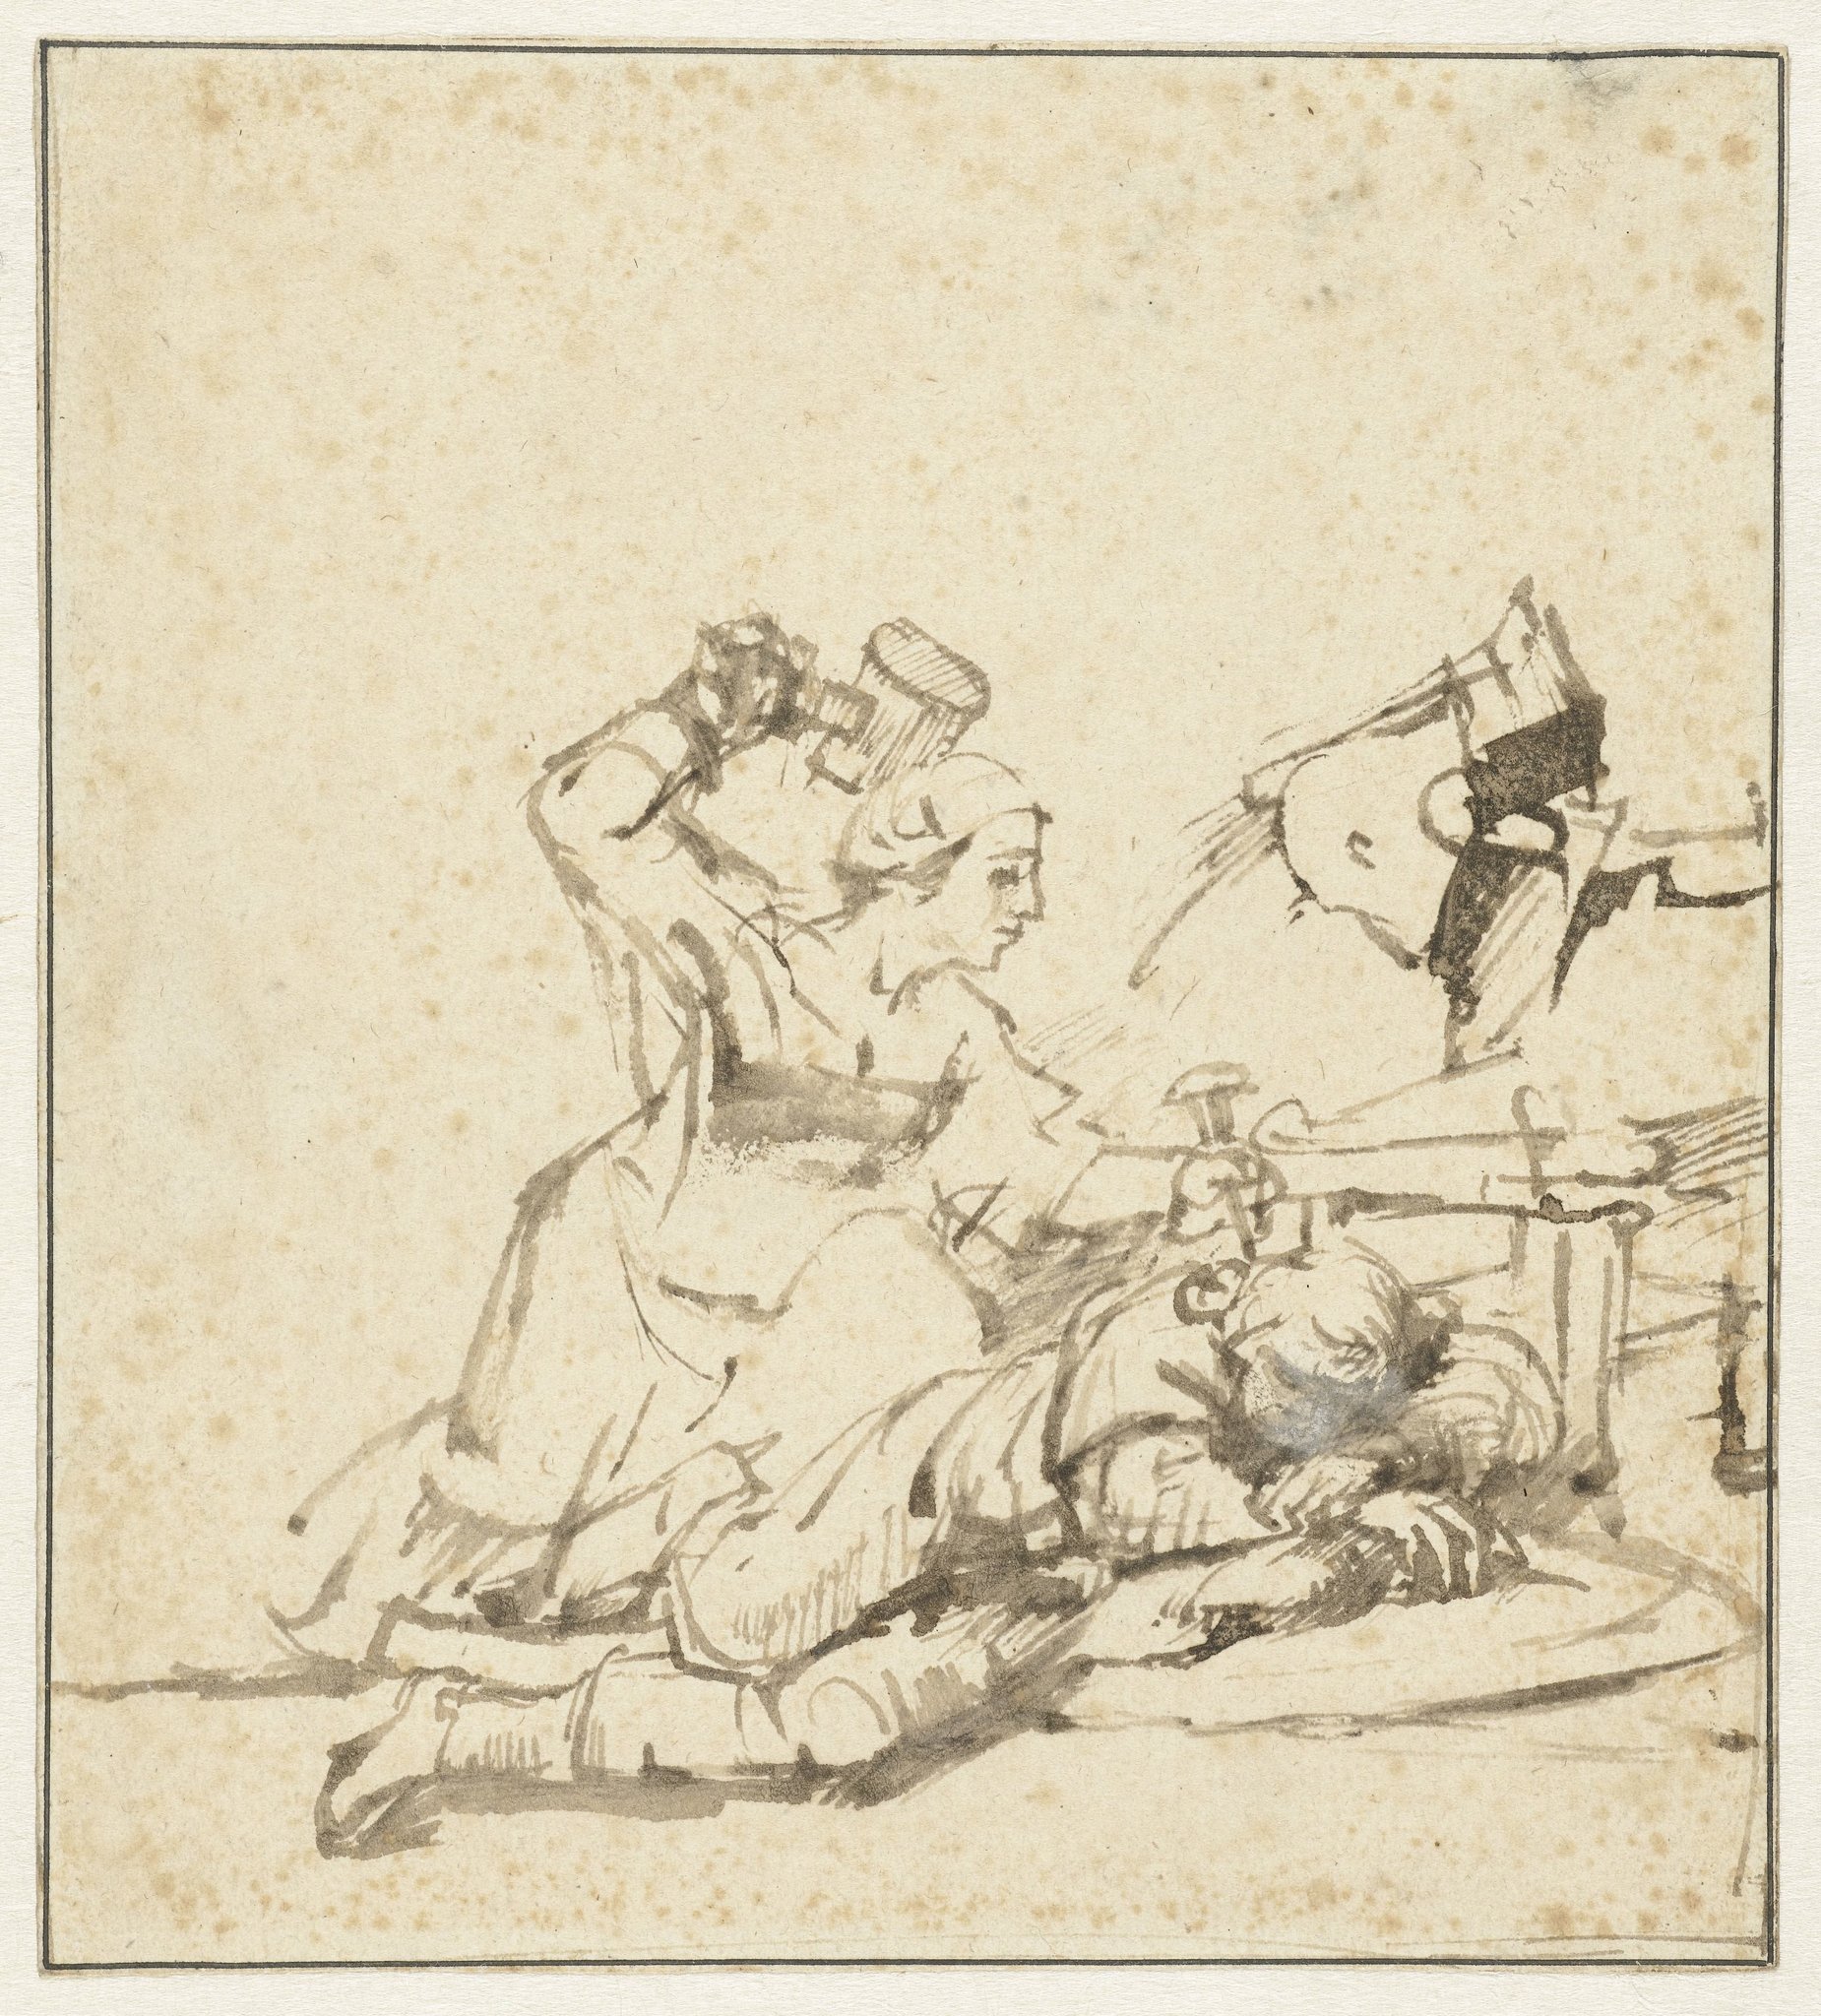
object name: drawing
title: Jael Killing Sisera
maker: rembrandt van rijn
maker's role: draughtsman, painter, print maker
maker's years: 1606-1669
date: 1658-1659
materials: paint, ink, paper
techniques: brush, pen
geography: amsterdam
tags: jael kills the sleeping sisera by hitting the nail through his temples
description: After suffering a crushing defeat against the Israelites, the Canaanite army general Sisera imagined he was safe in the tent of the Jewish Jael. However, as soon as he fell asleep, she killed him, driving a tent peg through his head. Rembrandt portrayed a determined Jael who does not doubt the necessity of her deed. Hanging casually from a chair, Sisera’s helmet underscores his naivety.